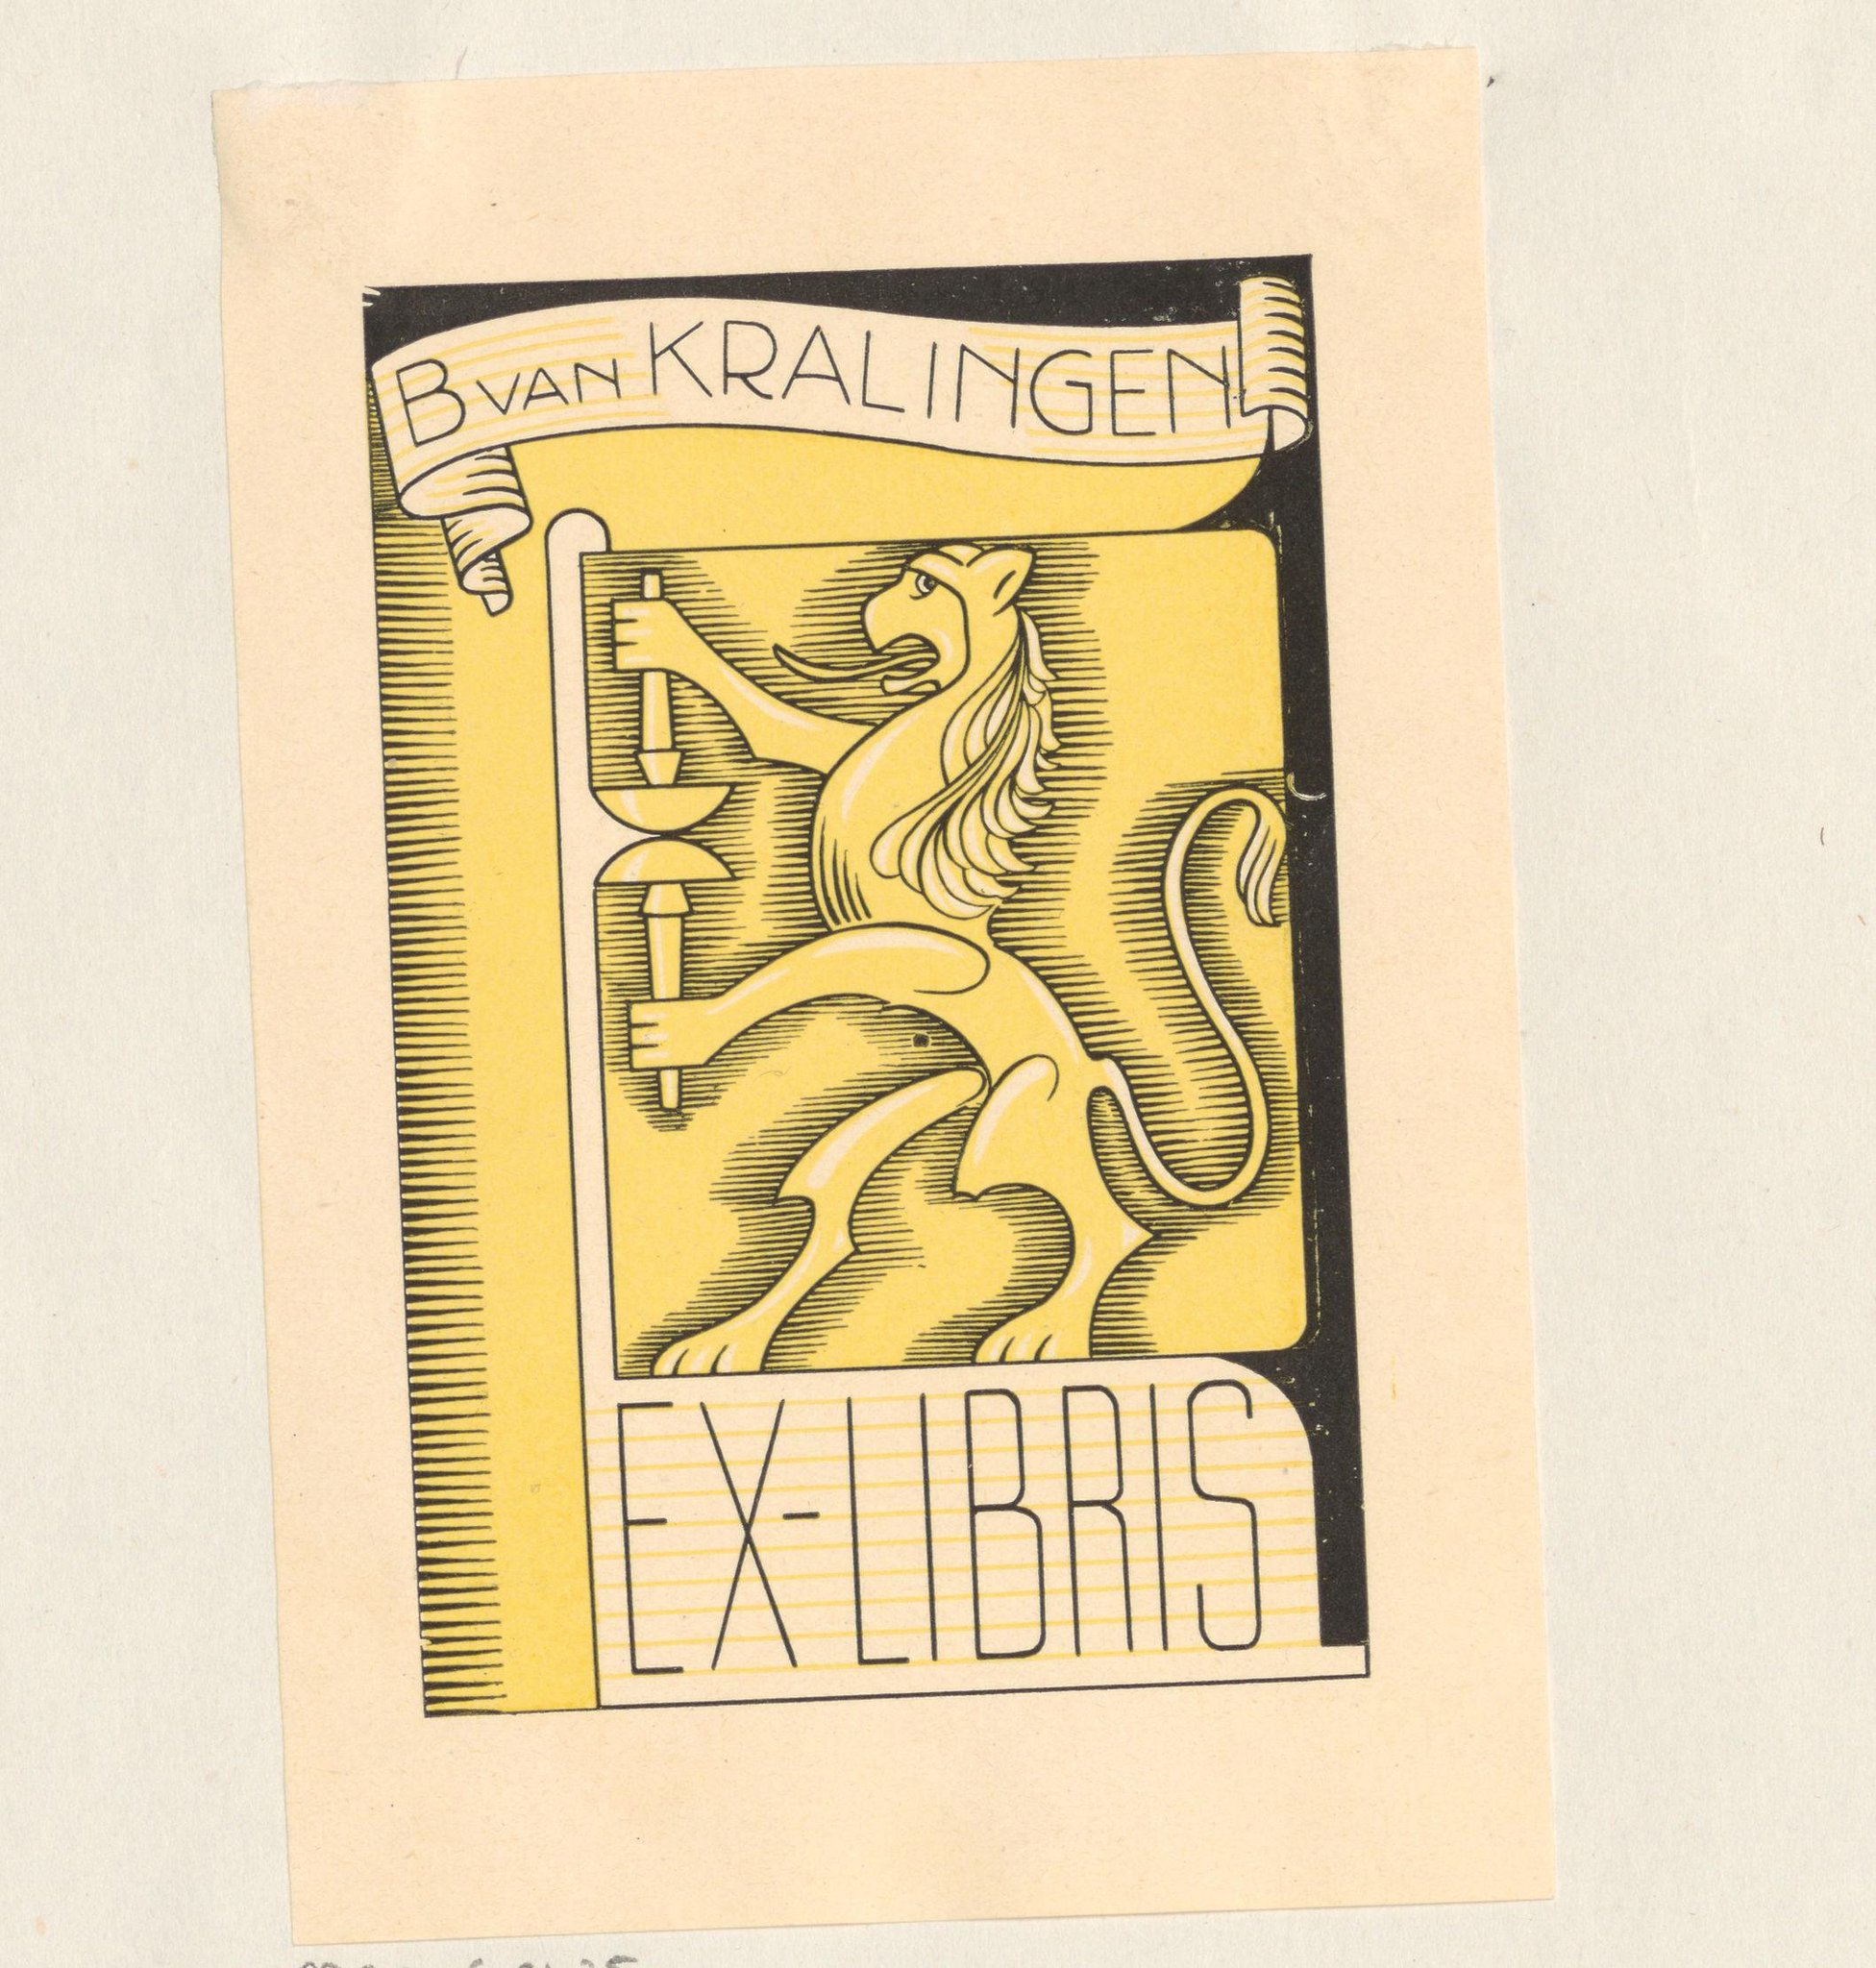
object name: bookplate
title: Ex libris van B. van Kralingen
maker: b. van kralingen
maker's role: print maker, printer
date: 1940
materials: paper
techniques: printing block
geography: netherlands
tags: printer, b. van kralingen, printing ~ applied arts, beasts of prey, predatory animals: lion, armorial bearing, heraldry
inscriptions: signature, date and inscription: ‘1940 cl eigen ontw.’